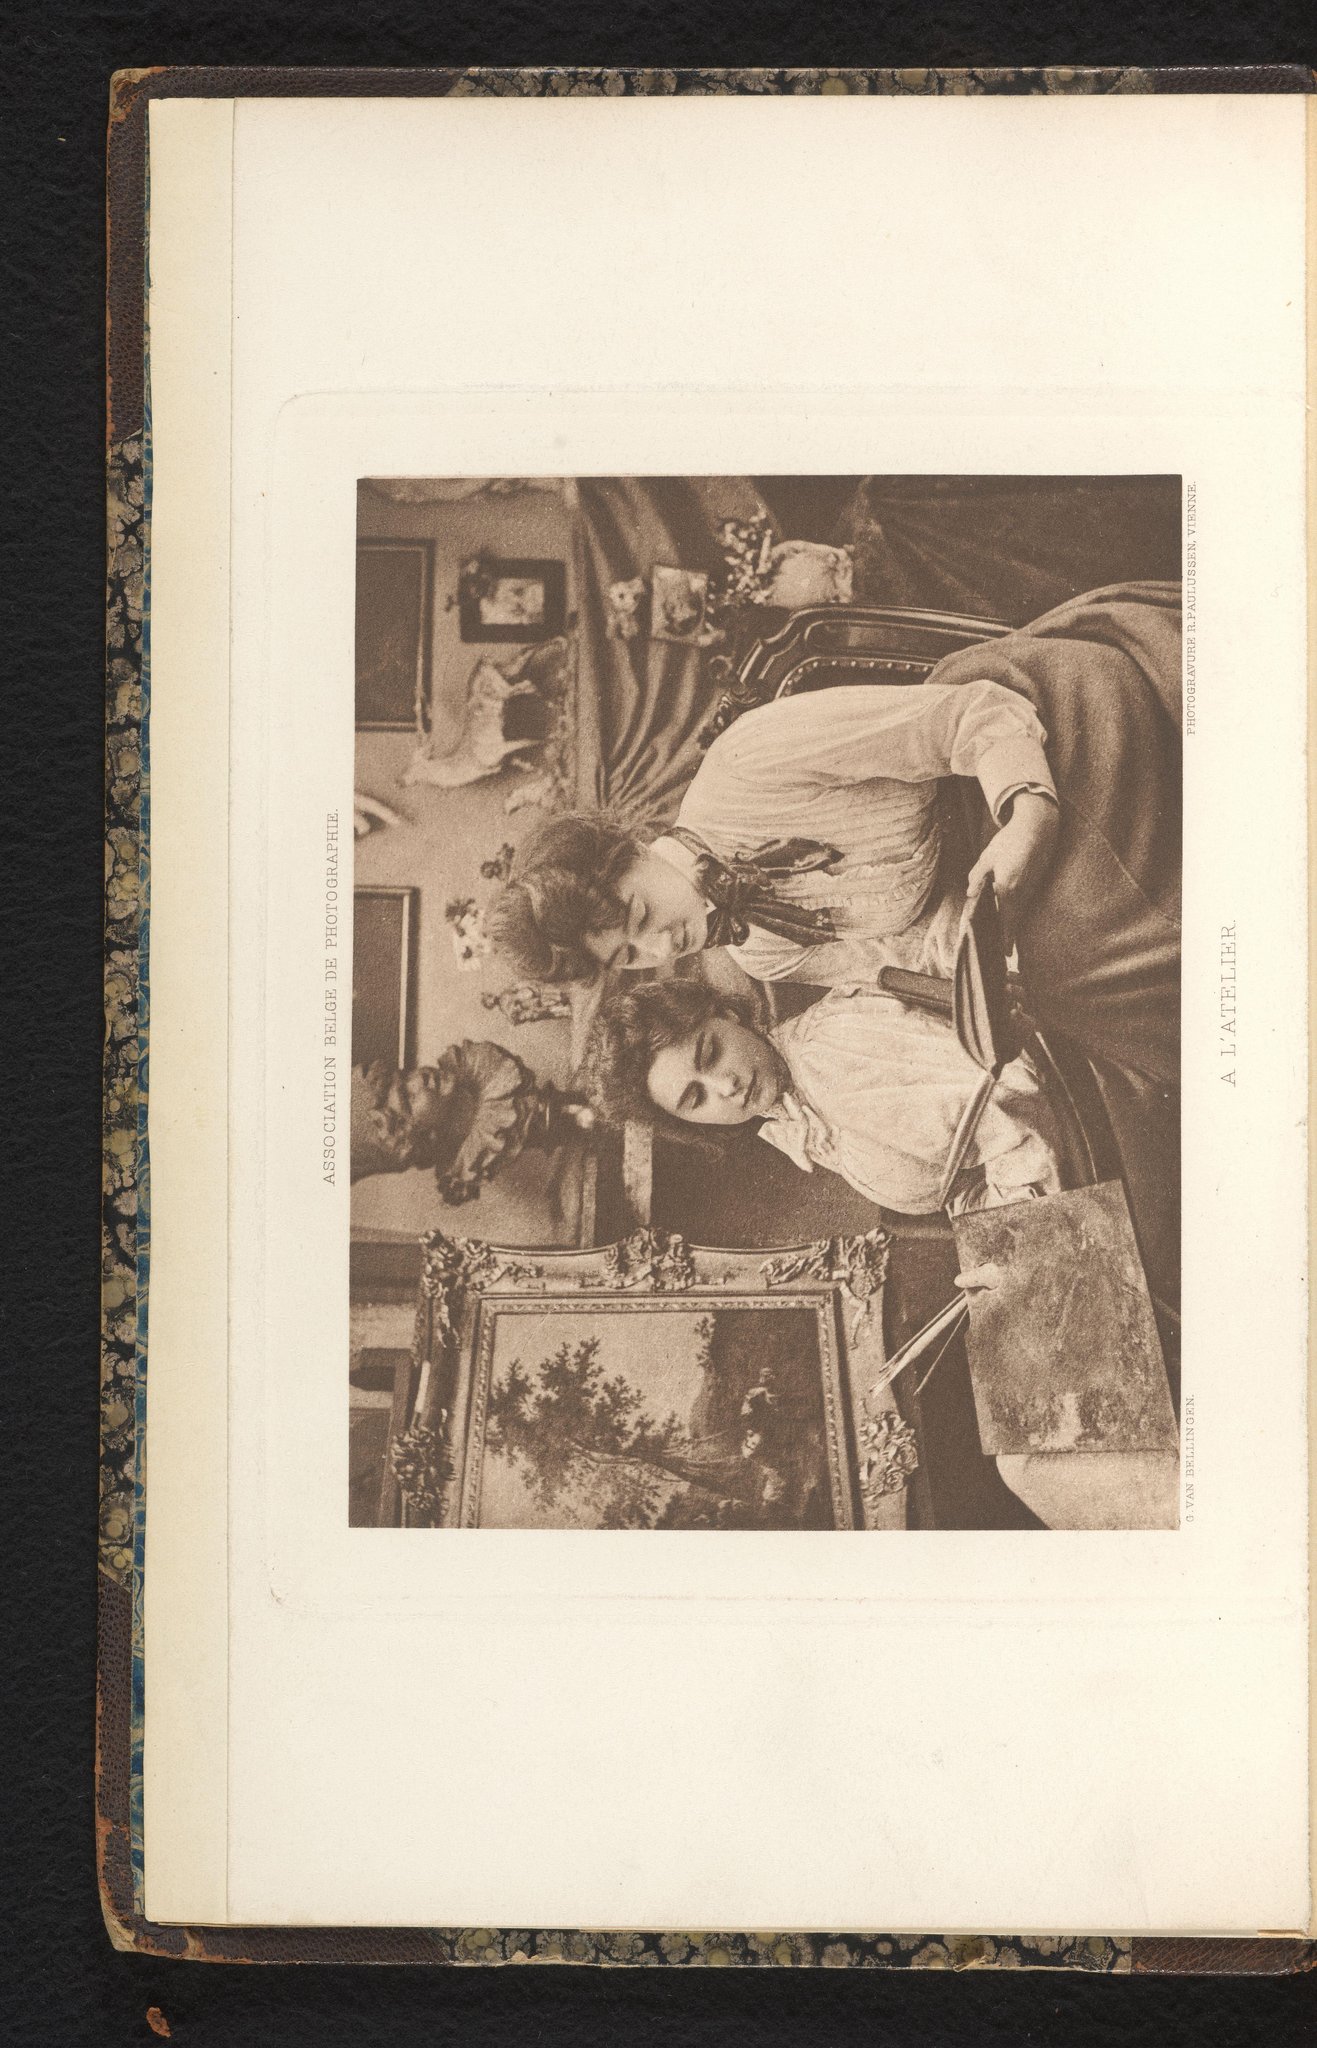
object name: page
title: A l'atelier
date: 1897-1902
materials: paper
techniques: photoaquatint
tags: adolescent, young woman, maiden, designing, sketching ~ architect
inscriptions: inscription: ‘Association belge de photographie’